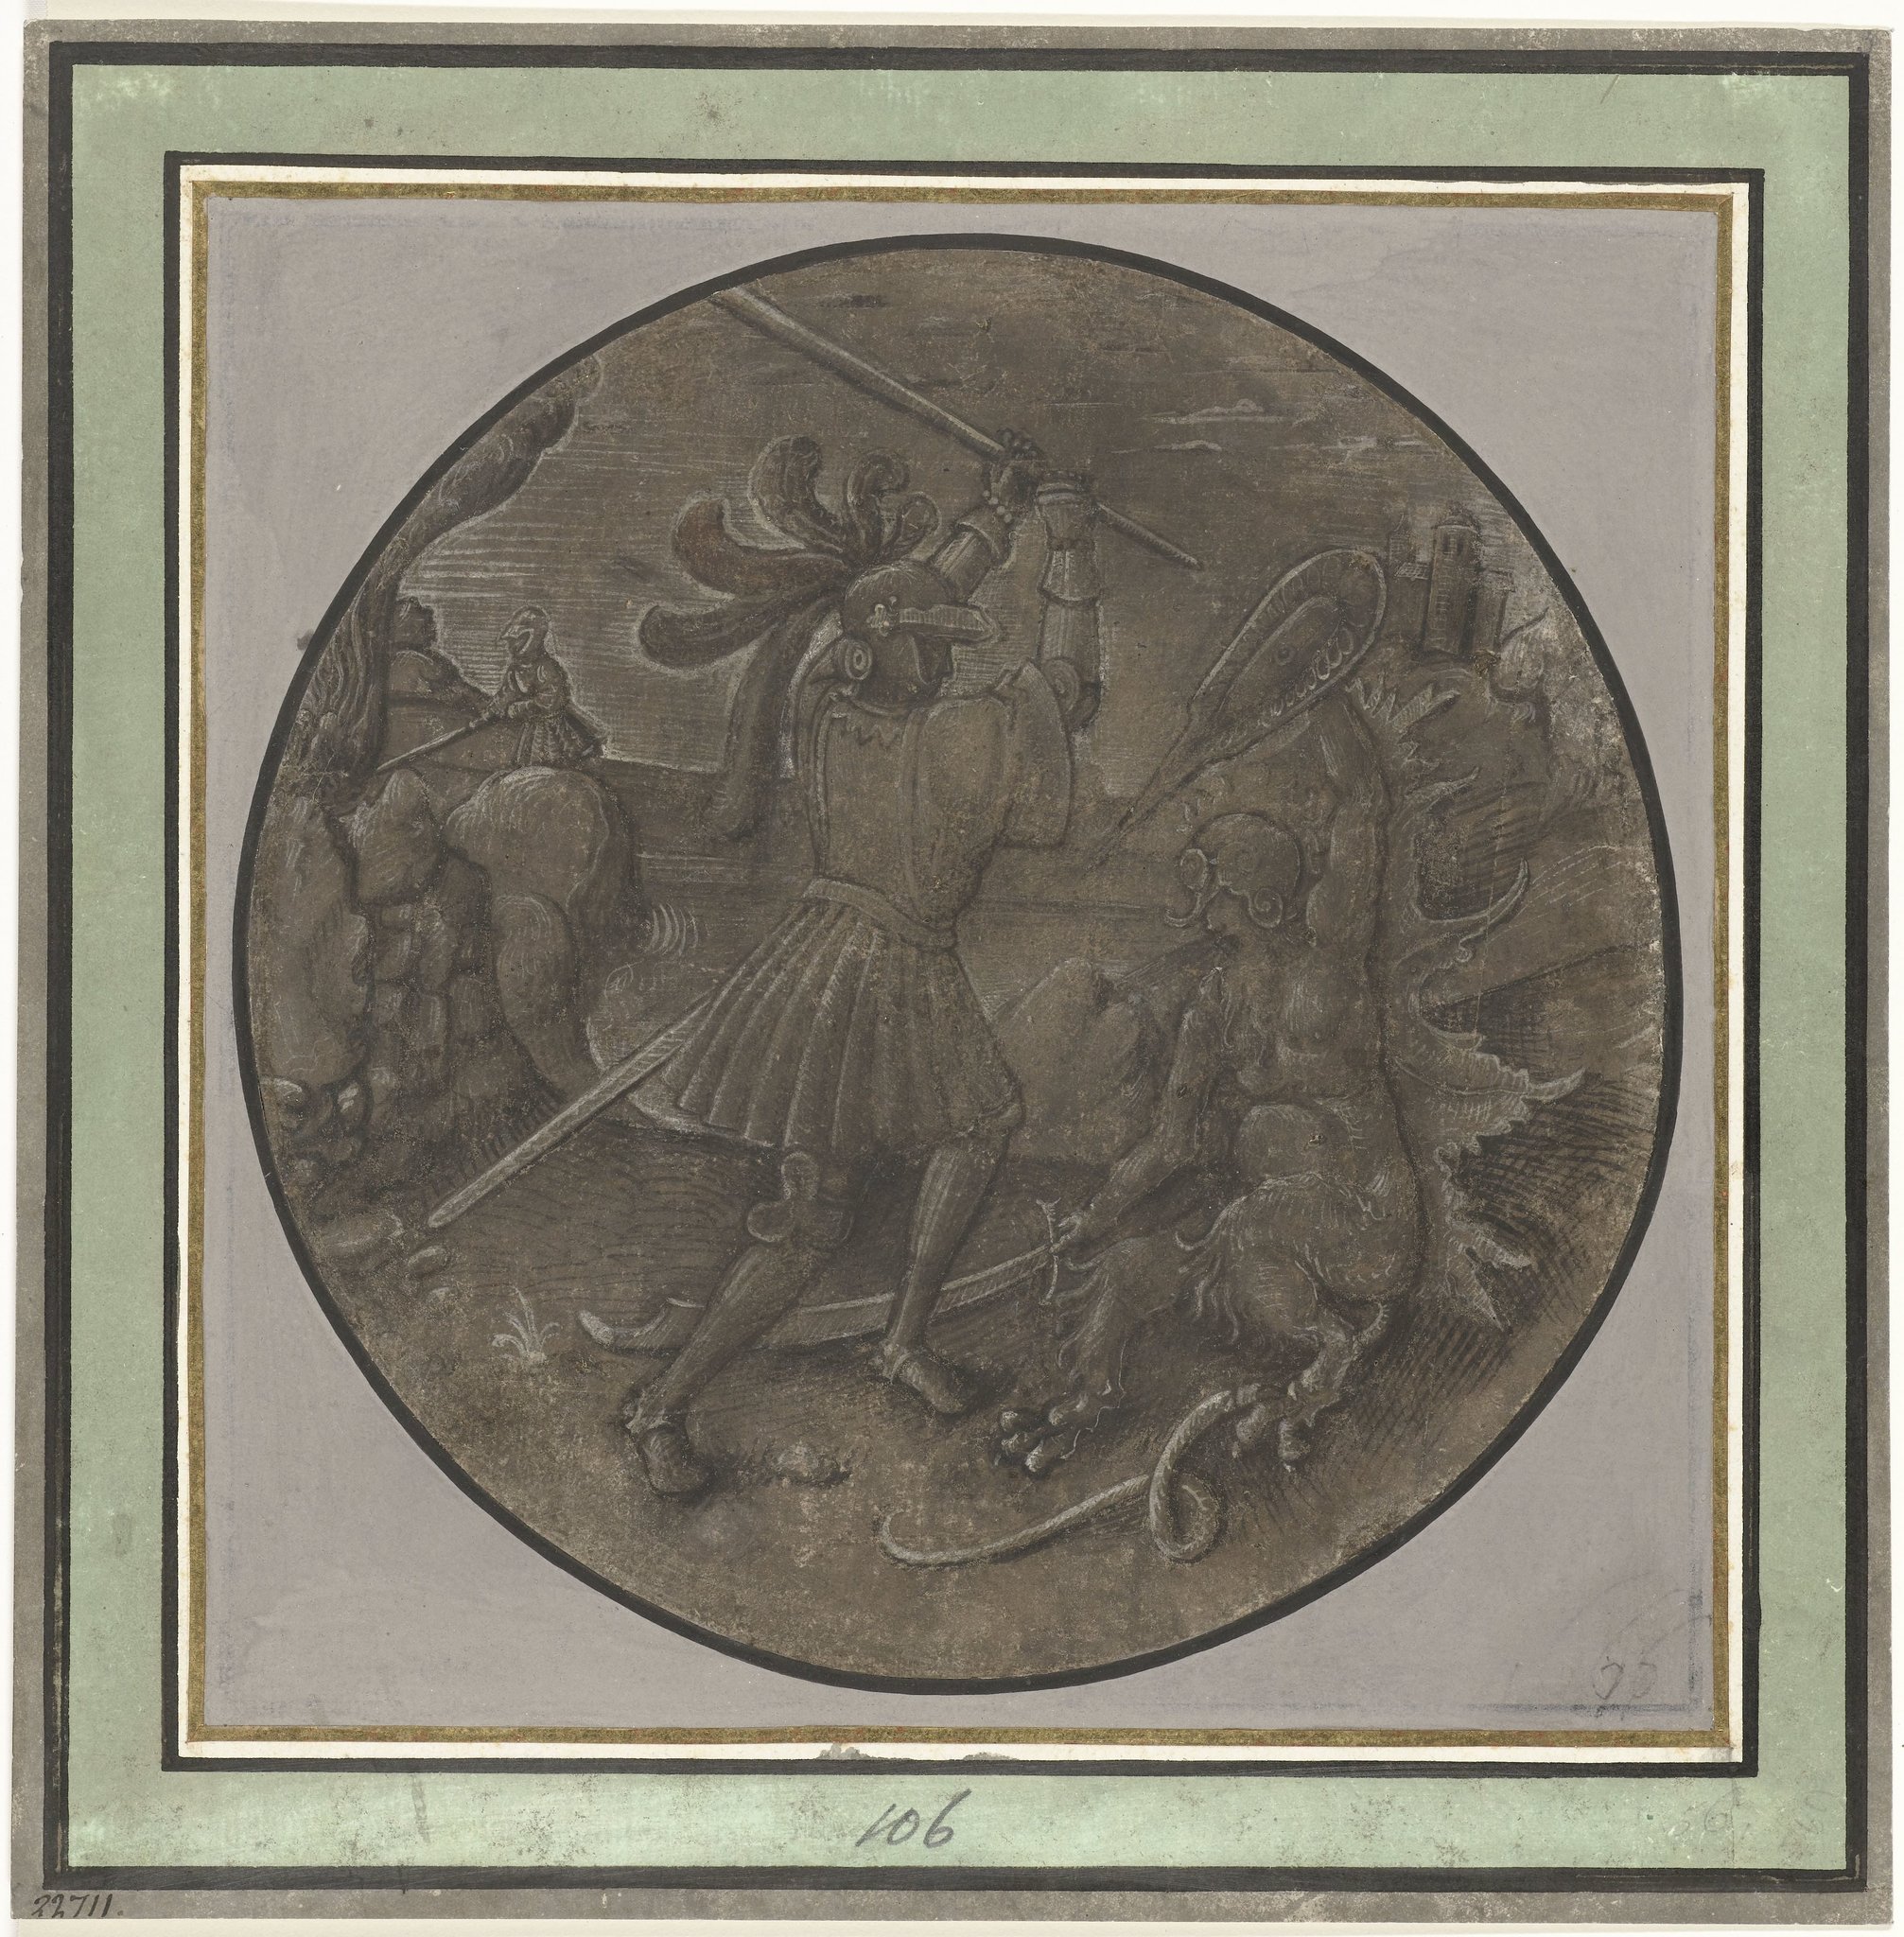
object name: drawing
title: Hercules verslaat de Hydra van Lerna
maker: Anonymous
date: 1510-1530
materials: ink, paint, paper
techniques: pen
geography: antwerp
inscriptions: collector's mark: ‘L. 2773’